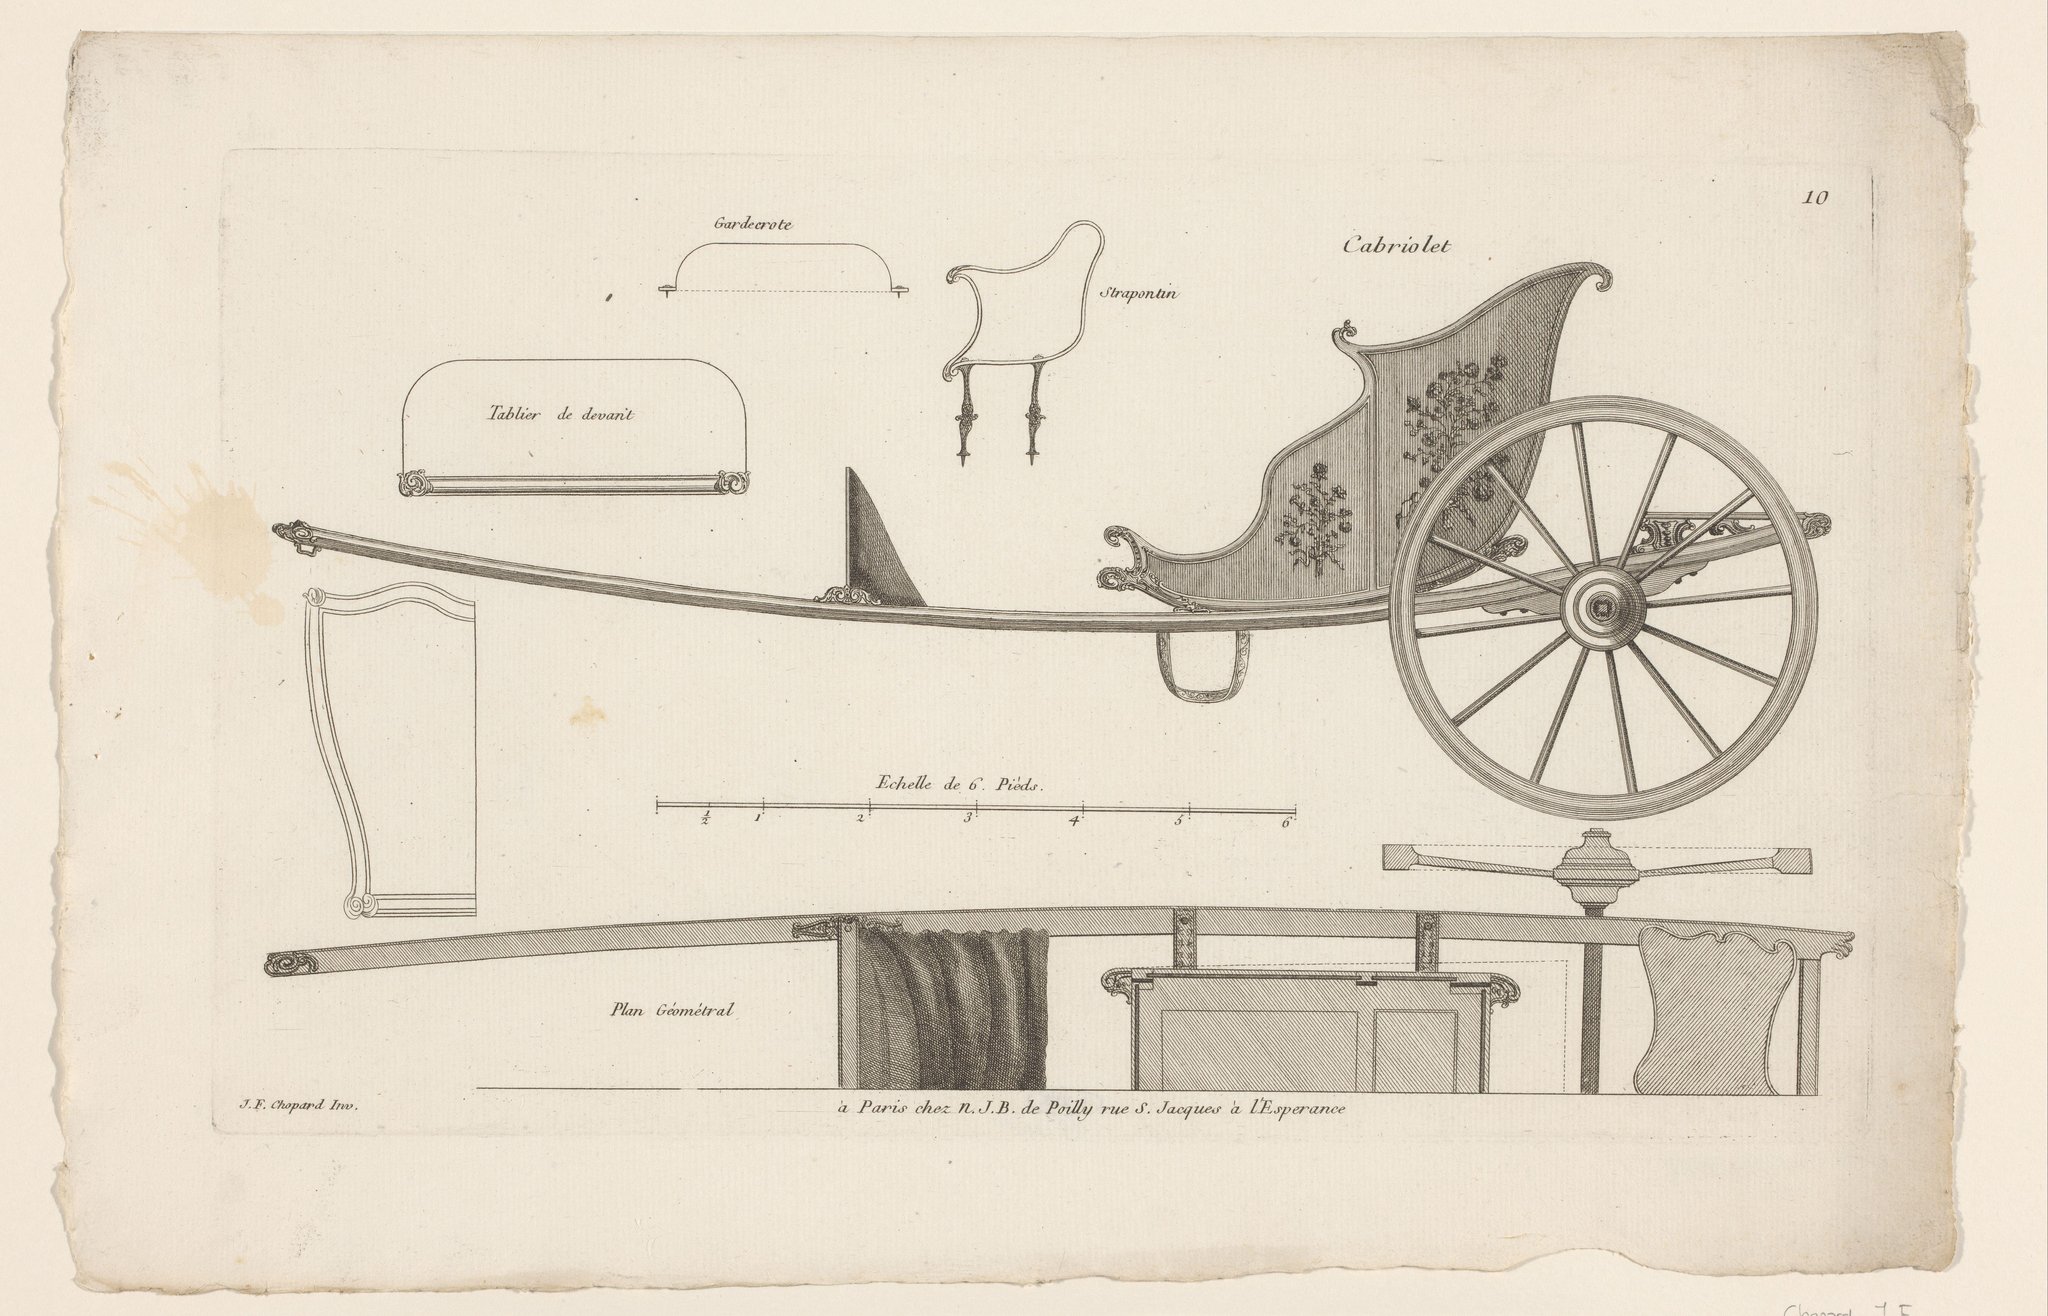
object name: ornament print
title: Cabriolet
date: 1740-1758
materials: paper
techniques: engraving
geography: paris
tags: four-wheeled, animal-drawn vehicle, e.g.: cab, carriage, coach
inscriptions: collector's mark: Lugt 2228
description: Cabriolet op twee wielen met bloemmotief. Een cabriolet is een open rijtuig.